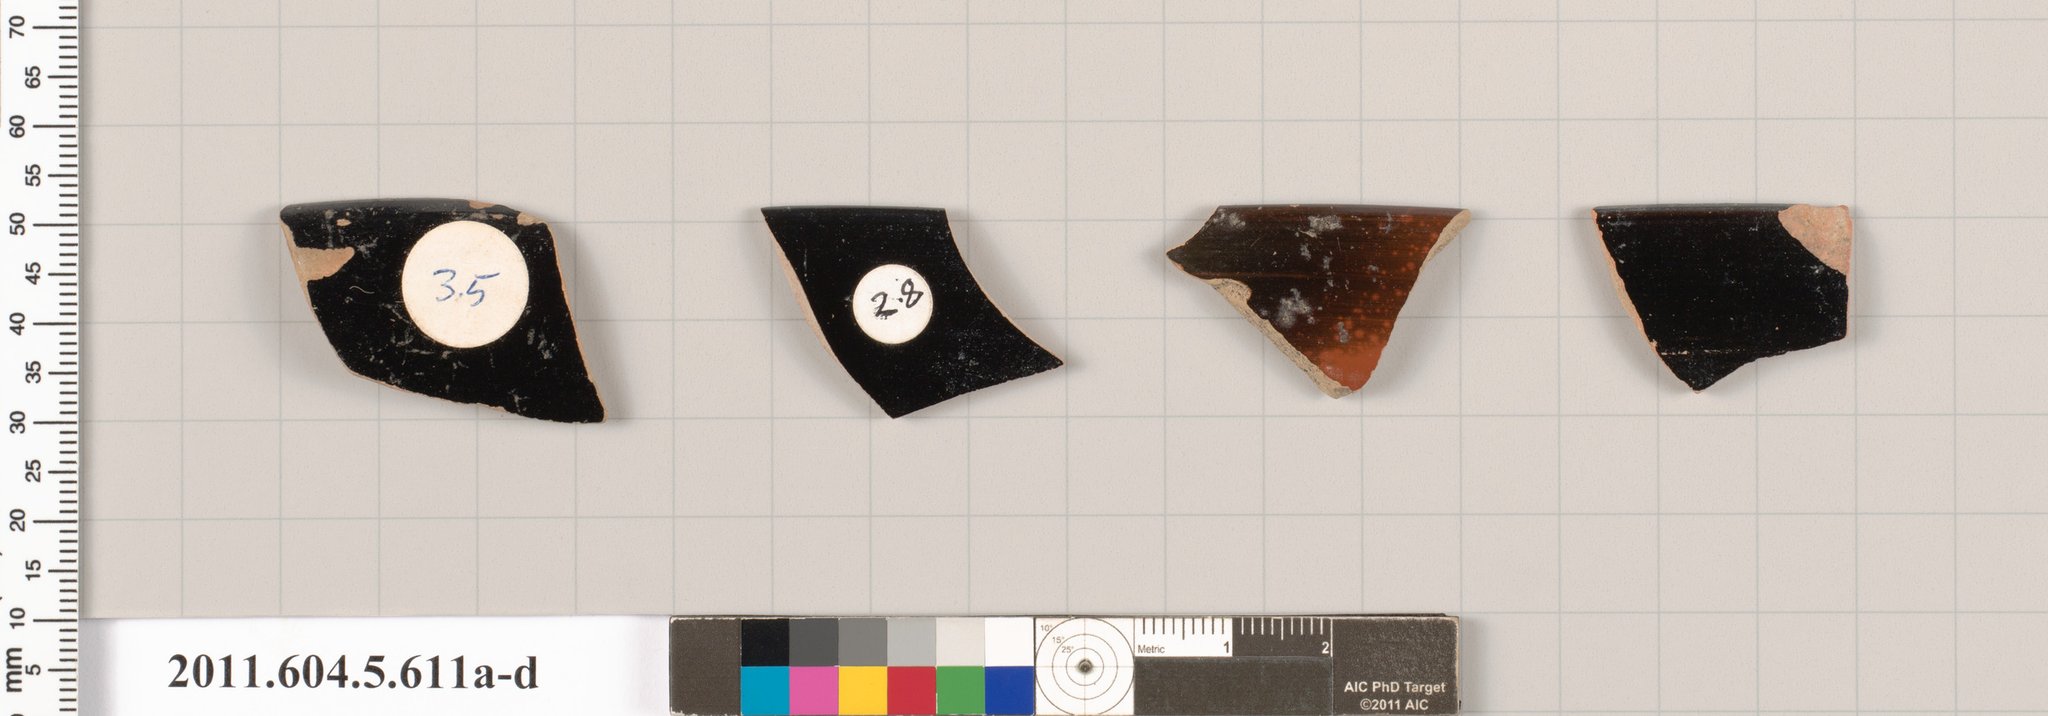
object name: kylix fragment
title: Terracotta rim fragments of kylikes (drinking cups)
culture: greek, attic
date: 600-401 BCE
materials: terracotta